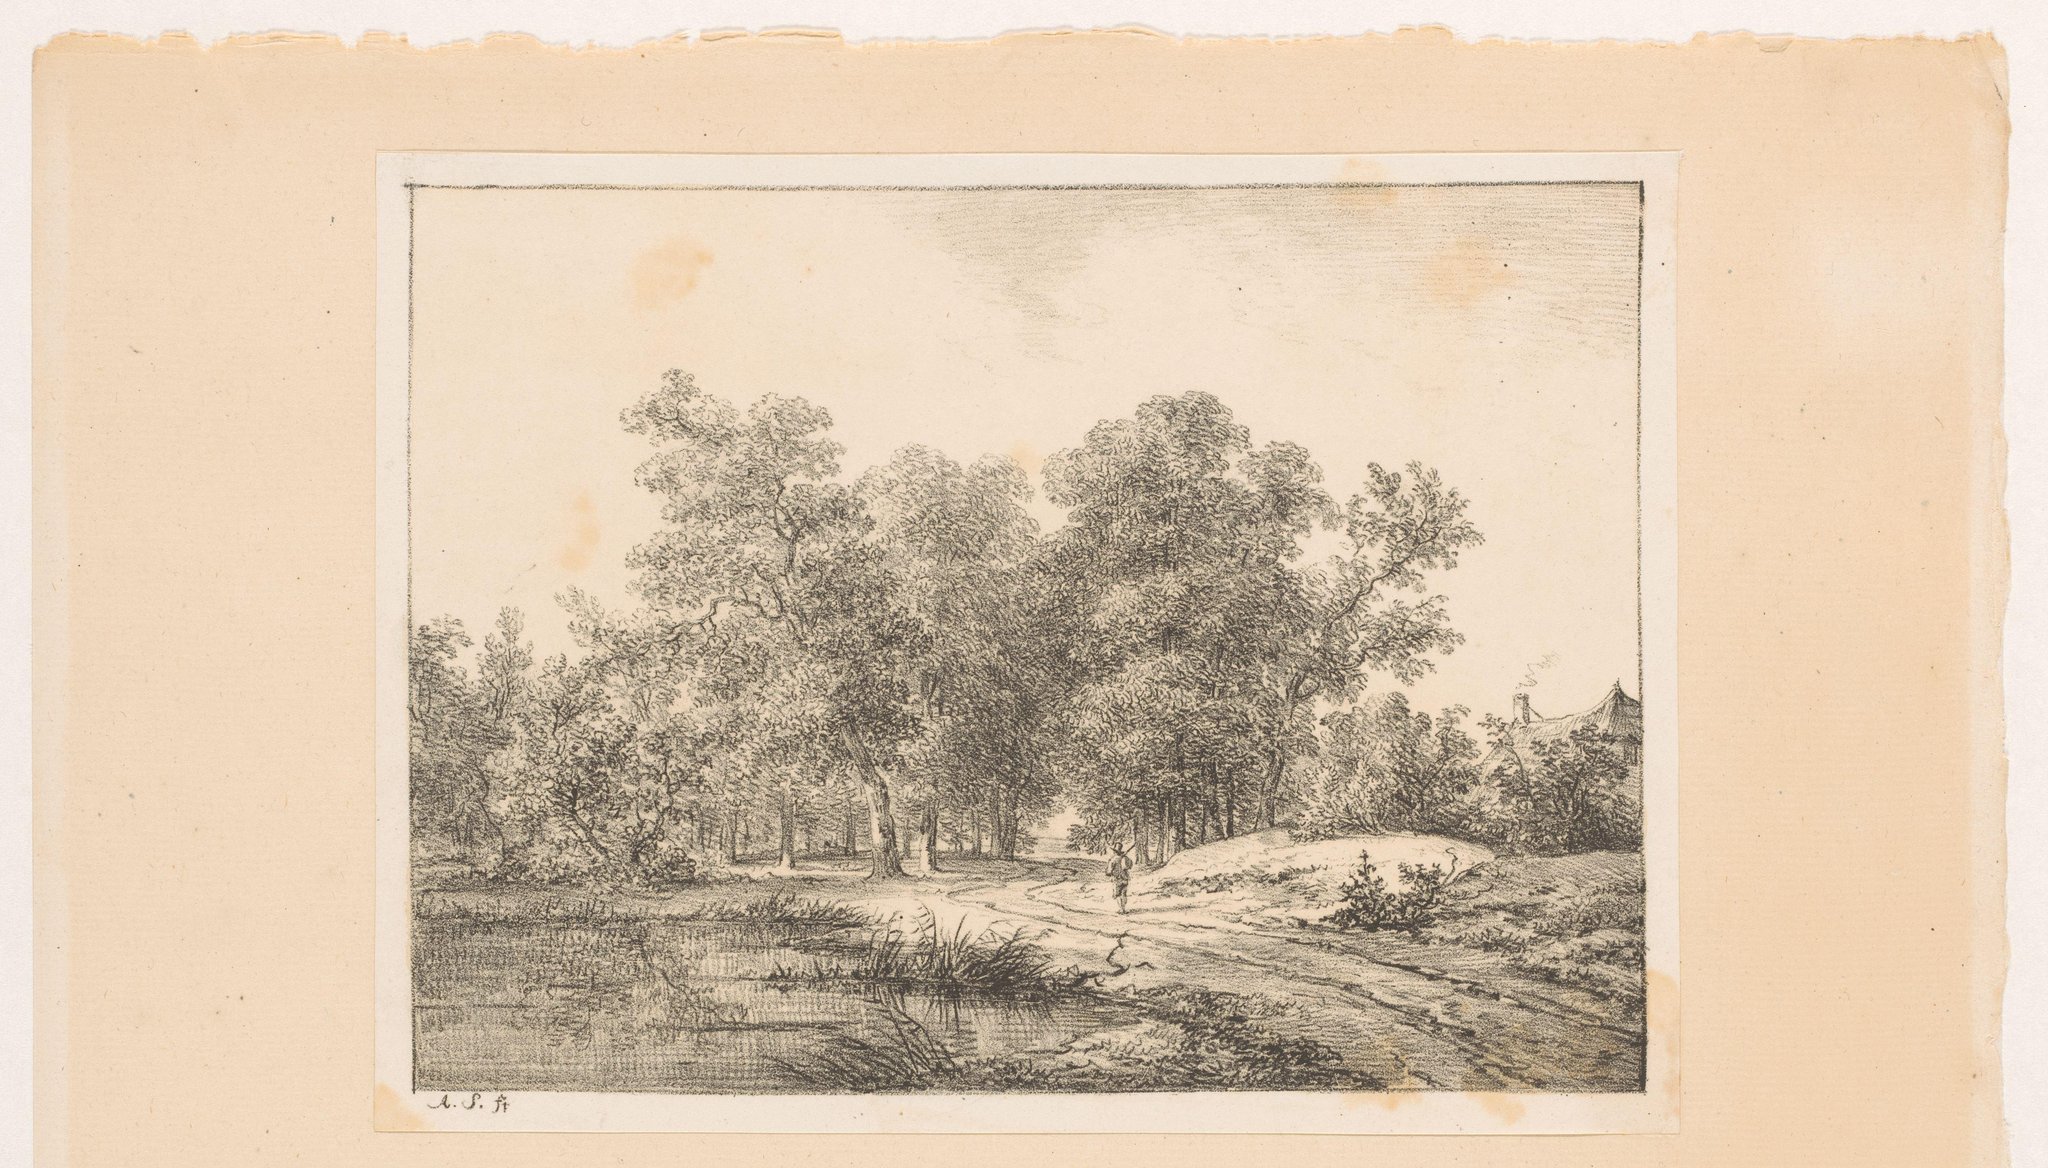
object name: print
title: Boslandschap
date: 1812-1832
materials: paper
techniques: lithograph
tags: forest, wood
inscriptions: collector's mark: Lugt 2760, collector's mark: Lugt 2166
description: In een bos loopt een man op een pad naast een poel. Rechts een huis.